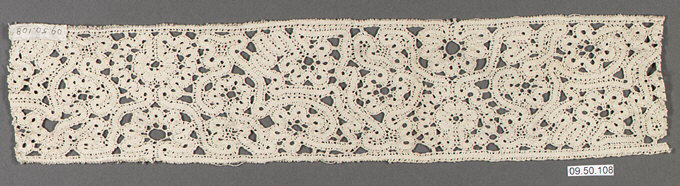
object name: strip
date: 1701-1800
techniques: lace